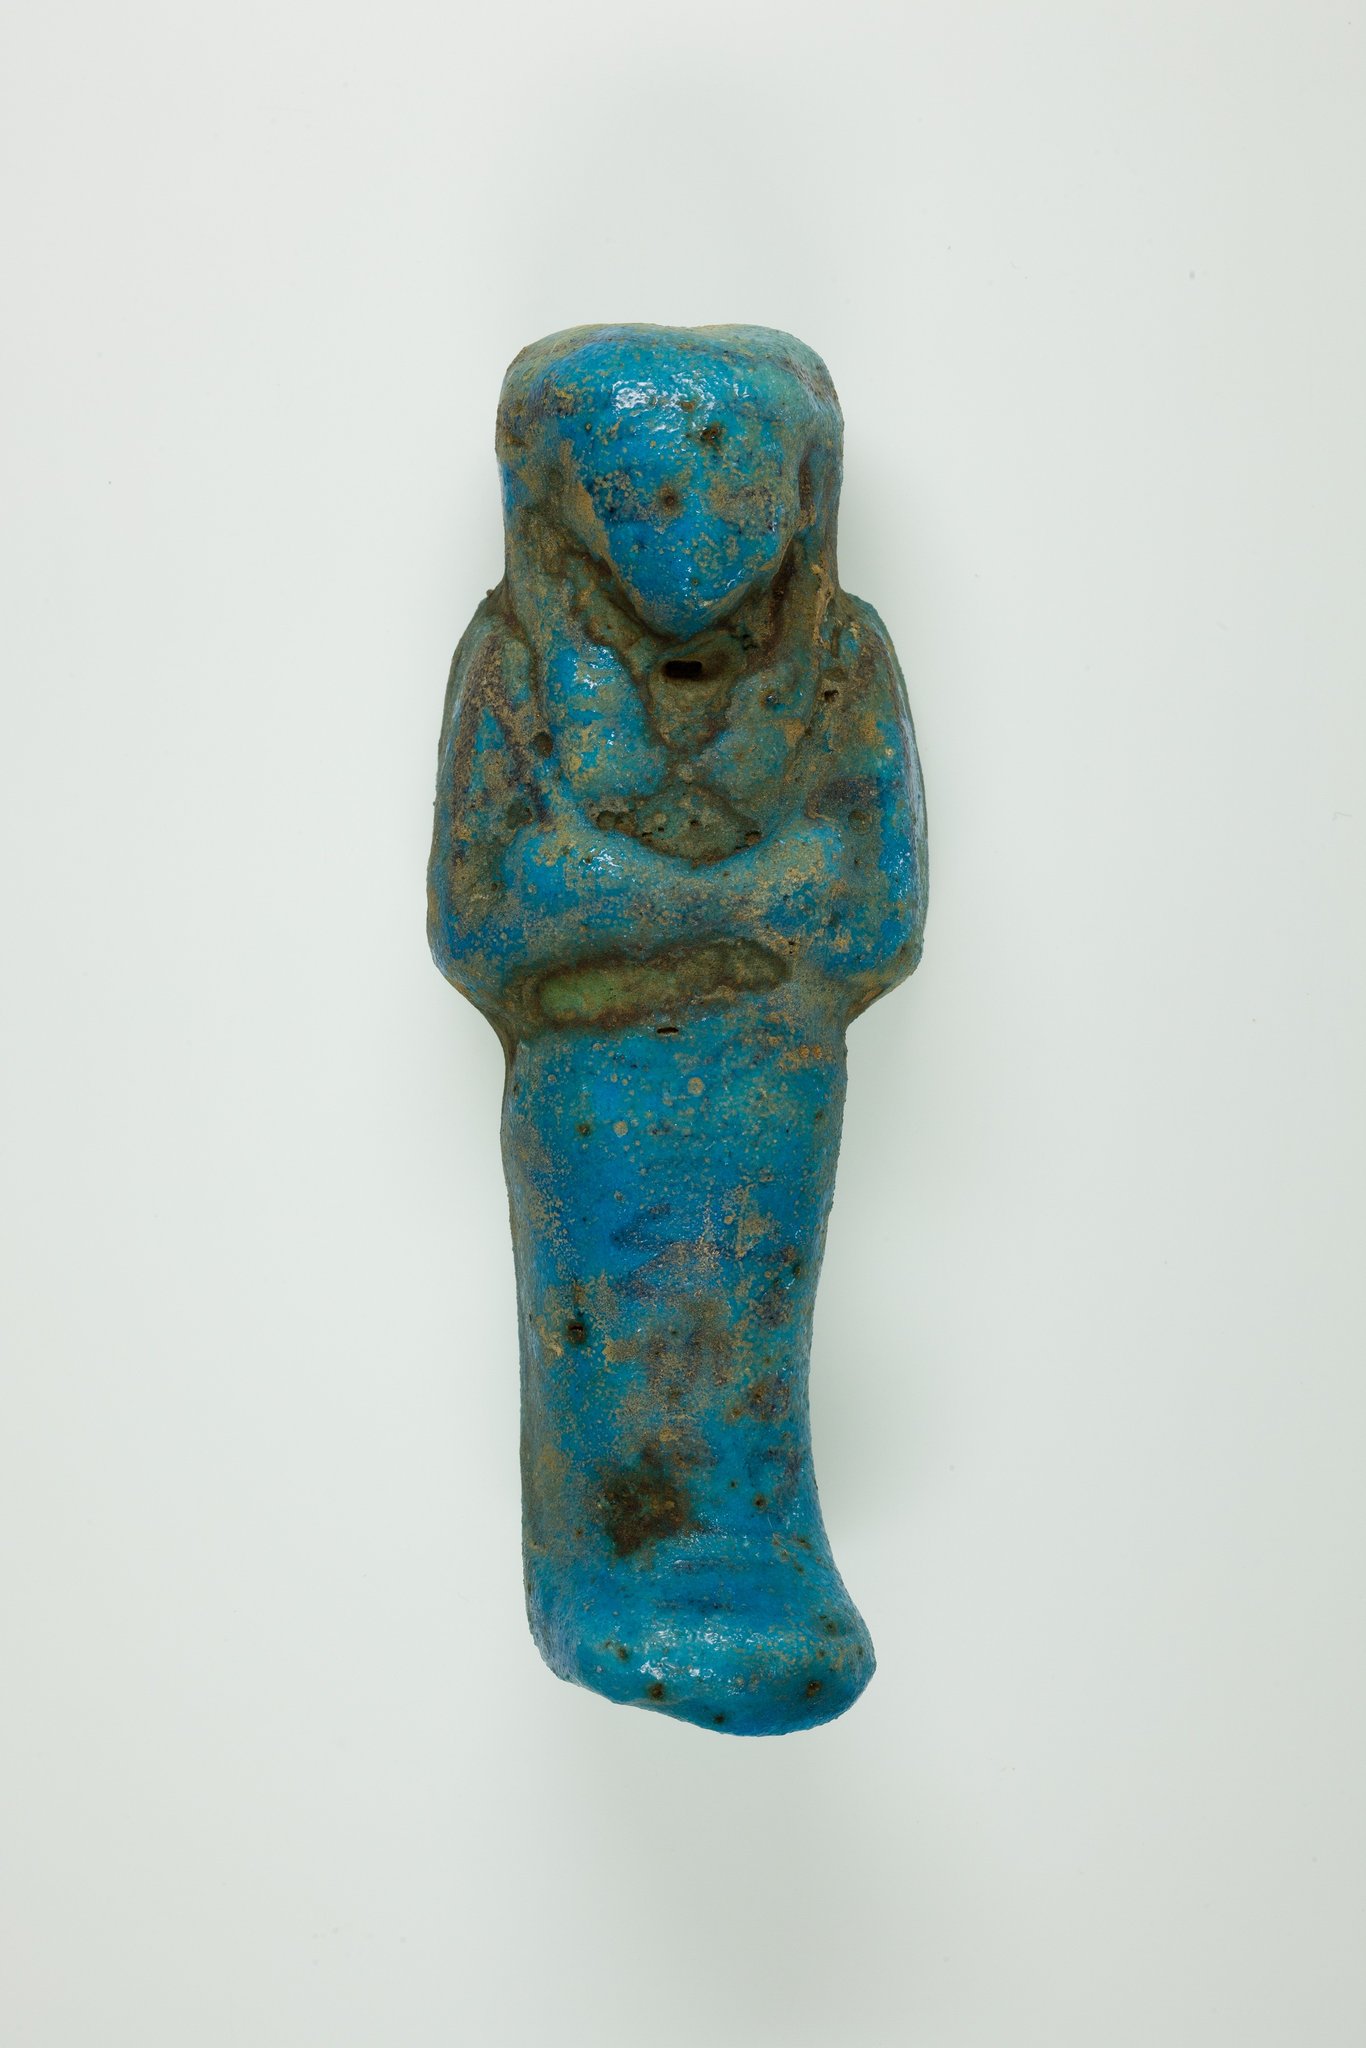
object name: worker shabti, henettawy c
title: Worker Shabti of Henettawy (C), Daughter of Isetemkheb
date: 990-970 BCE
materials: faience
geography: egypt